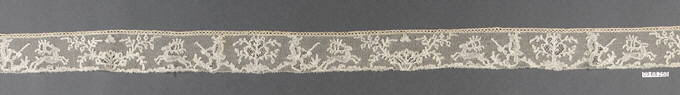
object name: border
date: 1701-1800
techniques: lace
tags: men,deer,flowers